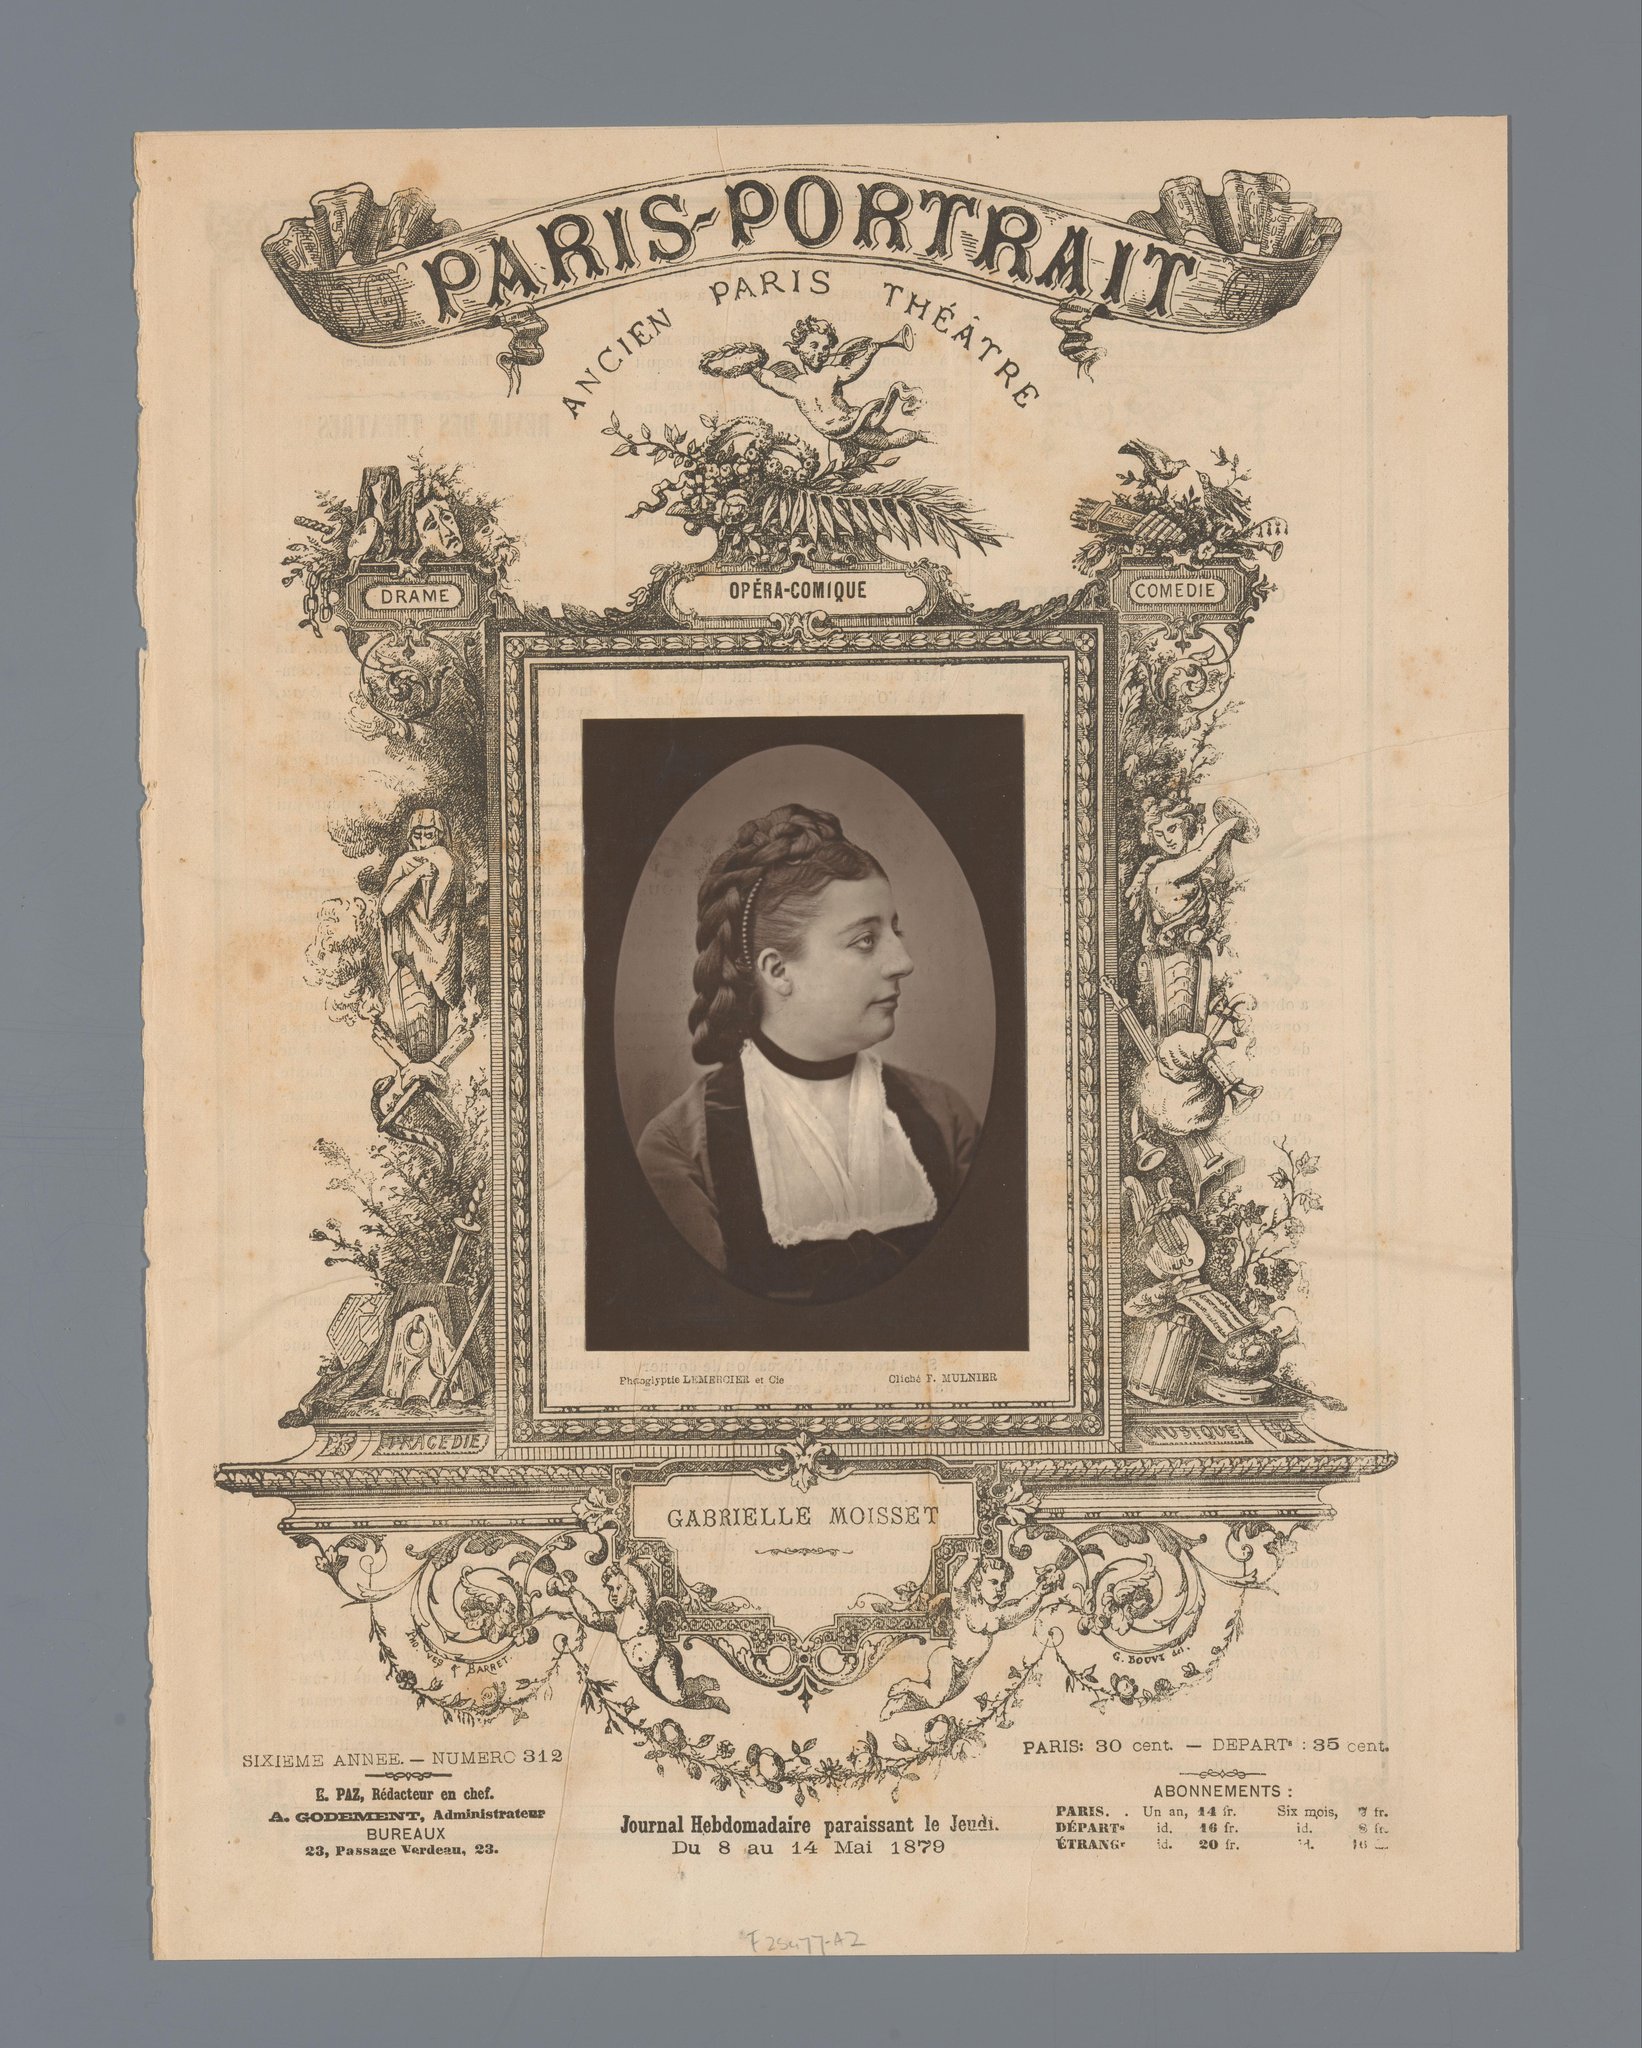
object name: photomechanical print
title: Portret van Gabrielle Moisset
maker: ferdinand mulnier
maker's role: painter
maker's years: 1817-1891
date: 1873-1880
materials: paper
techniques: woodburytype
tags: historical persons - bb - woman, portrait of opera-singer